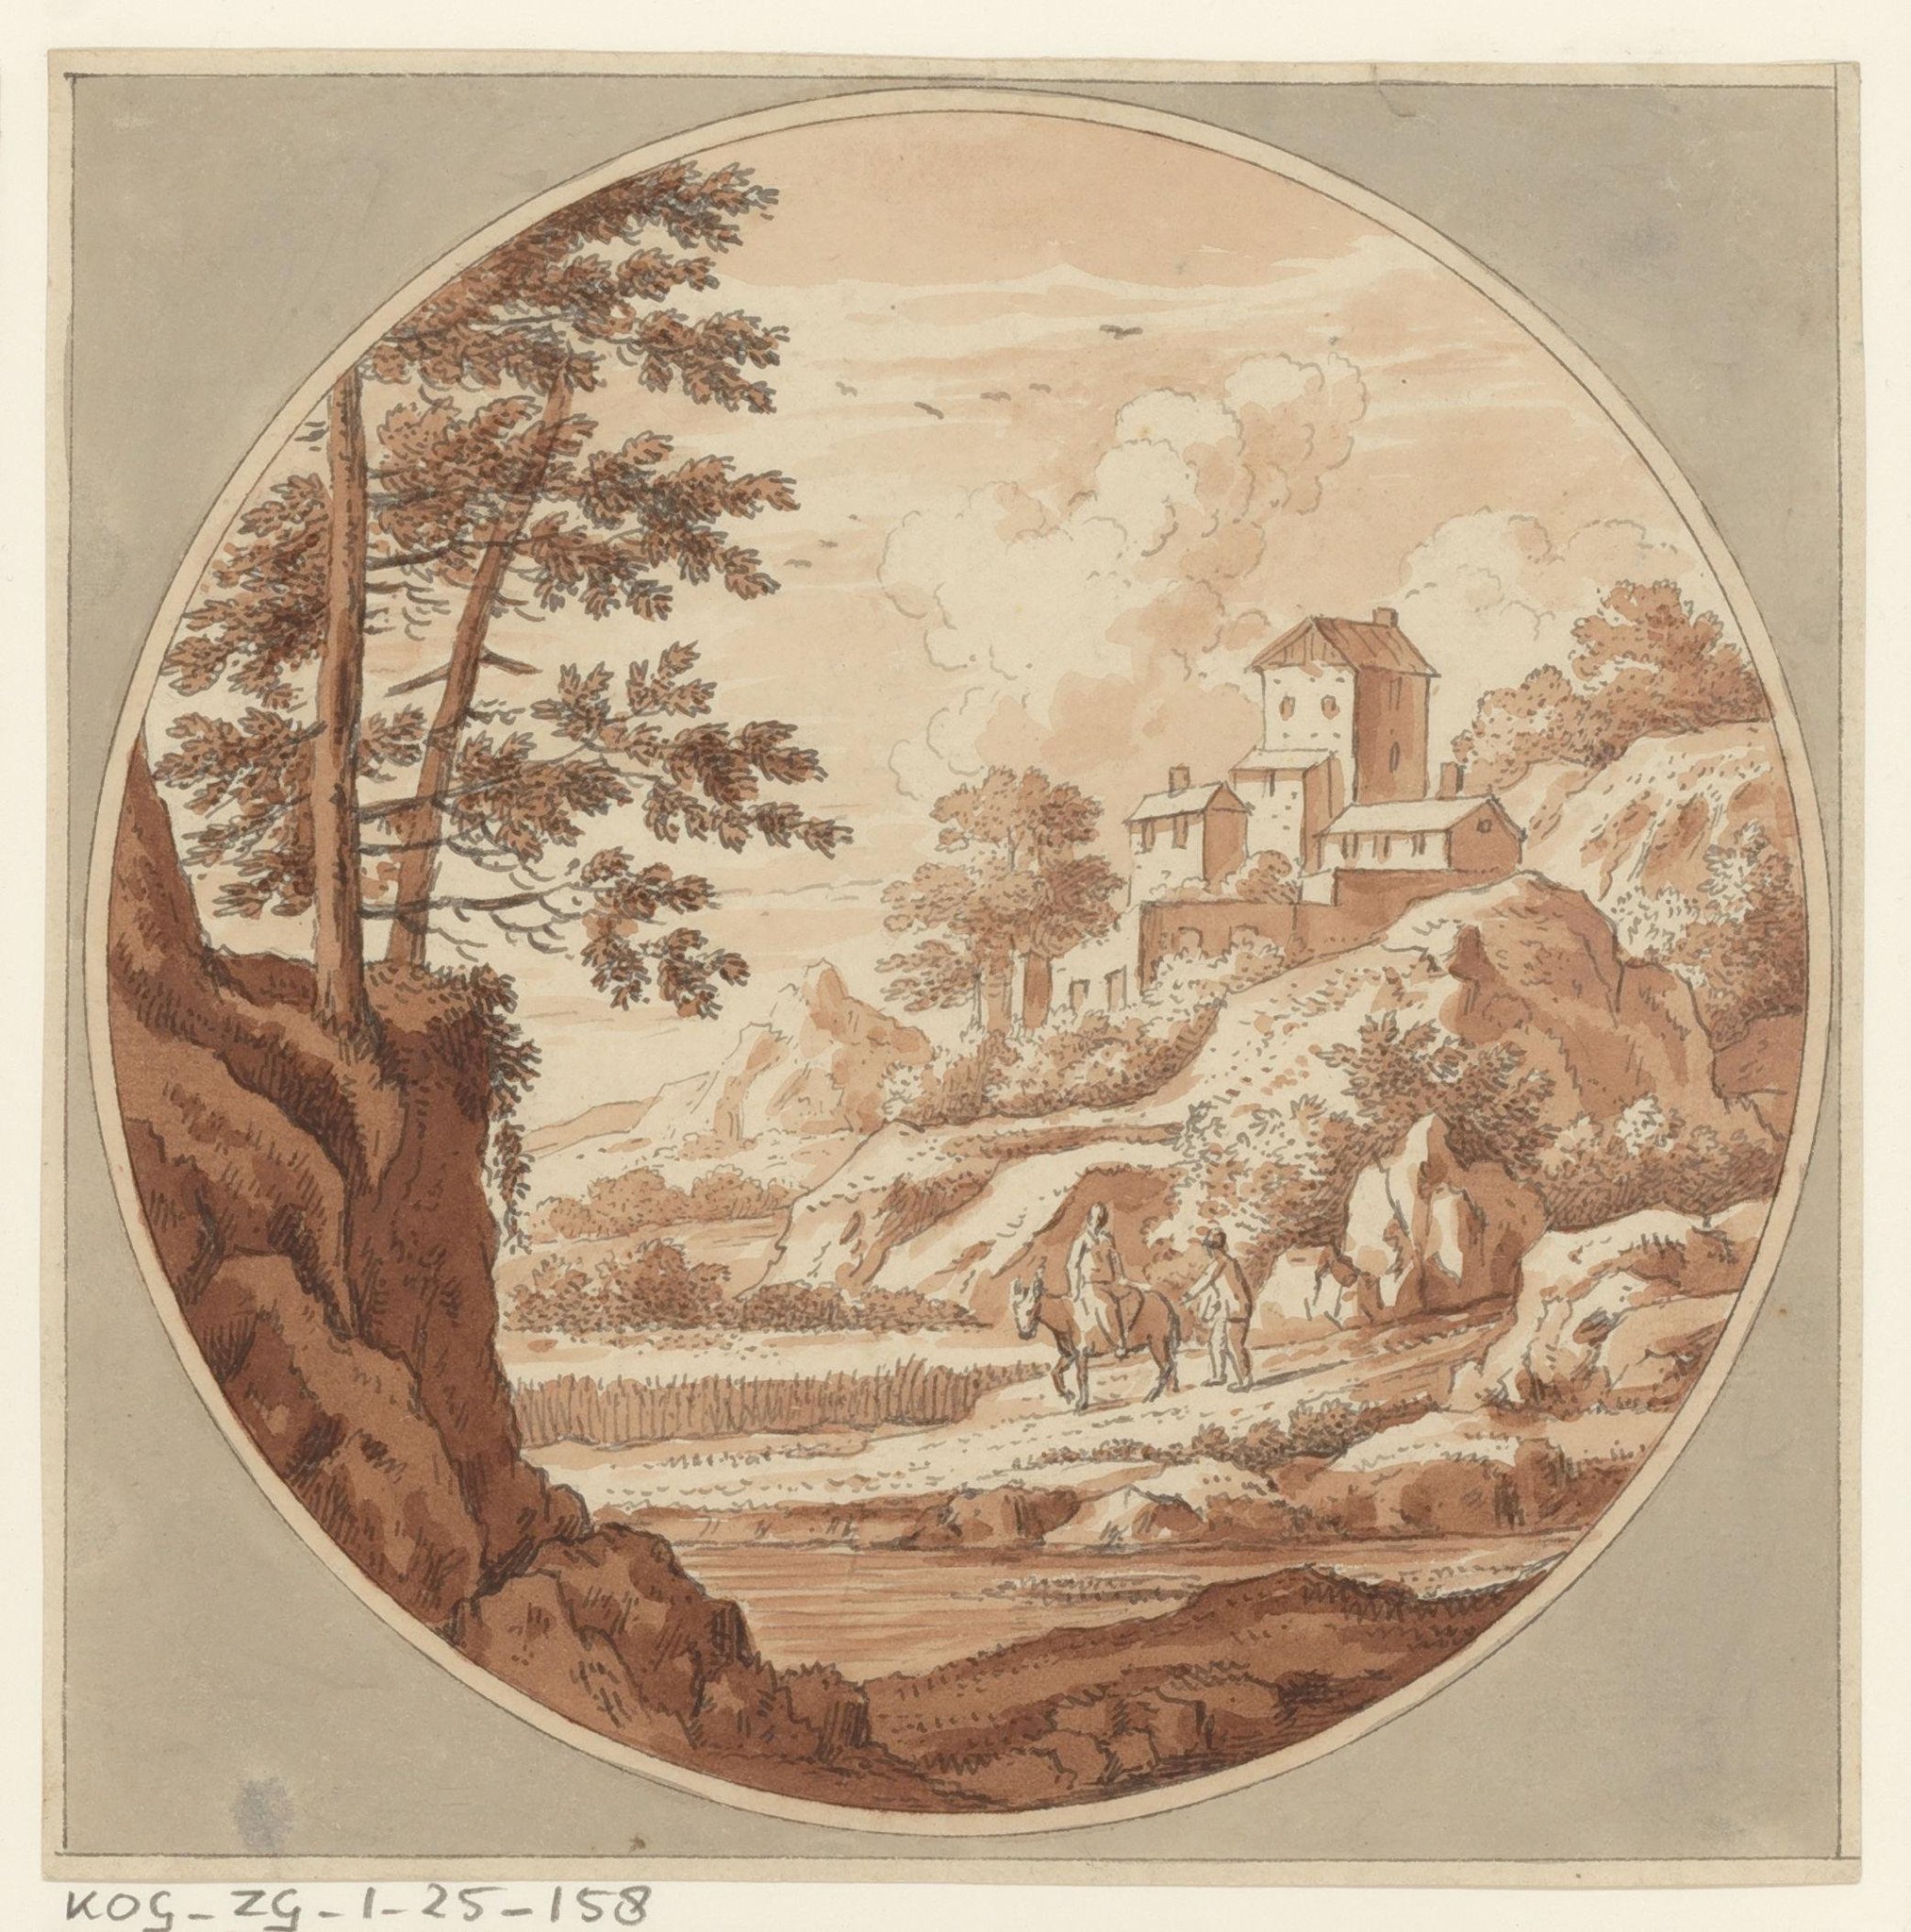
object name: drawing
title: Twee reizigers met ezel in een rotsachtig landschap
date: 1779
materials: ink, paper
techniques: brush, pen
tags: ass, donkey, rock-formations, 'en route', traveller under way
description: Naar een Delfts tafelbord. Onderwerpsrubrieken binnen de Atlas Zeden en Gewoonten: Zeden en Gewoonten in Engeren Zin, De Woning, Huisraad, Aardewerk.